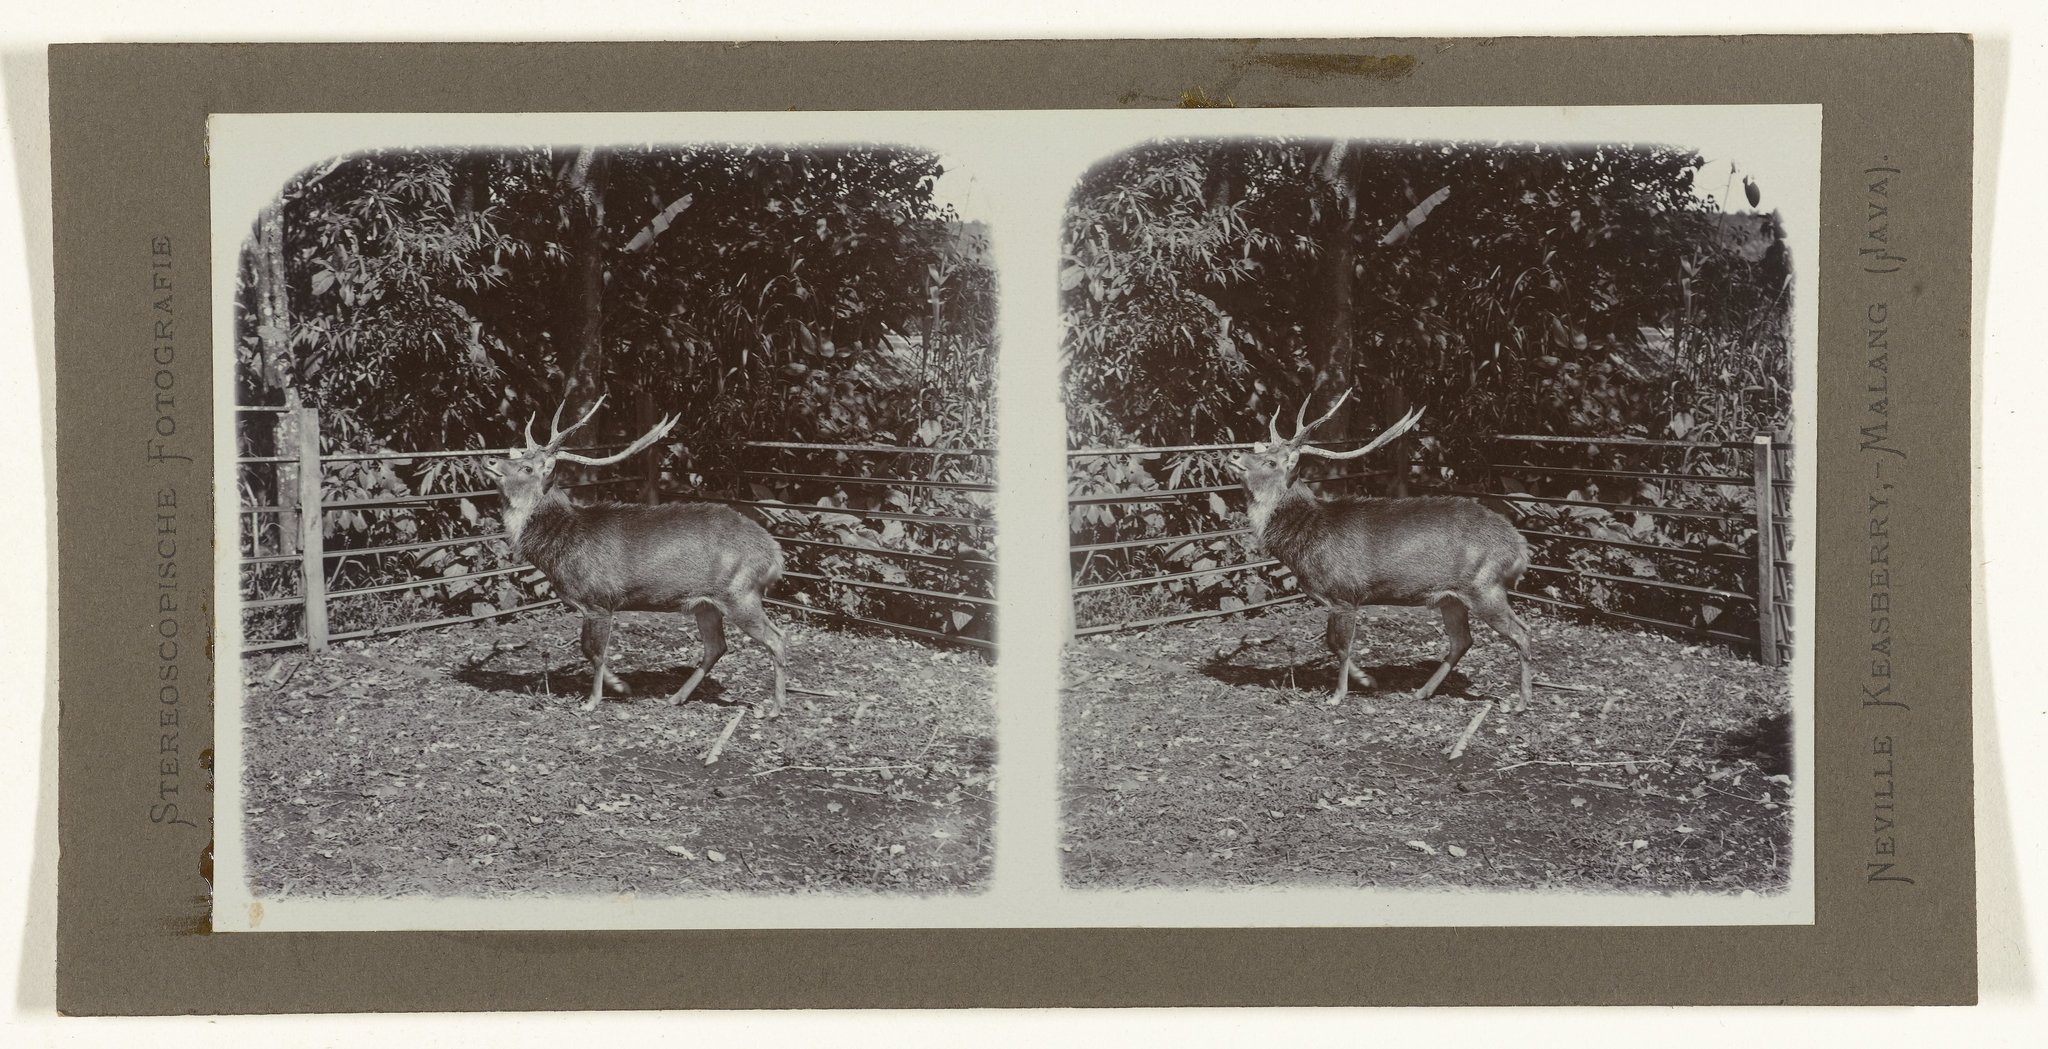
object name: stereograph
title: S 7 No 79. Een javaansch hert.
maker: neville keasberry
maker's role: fotograaf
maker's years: 1866-1944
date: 1900-1935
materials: cardboard, paper, photographic support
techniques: albumen print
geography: malang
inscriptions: signature: ‘Neville Keasberry, Malang (Java)’, inscription: ‘Stereoscopische Fotografie’